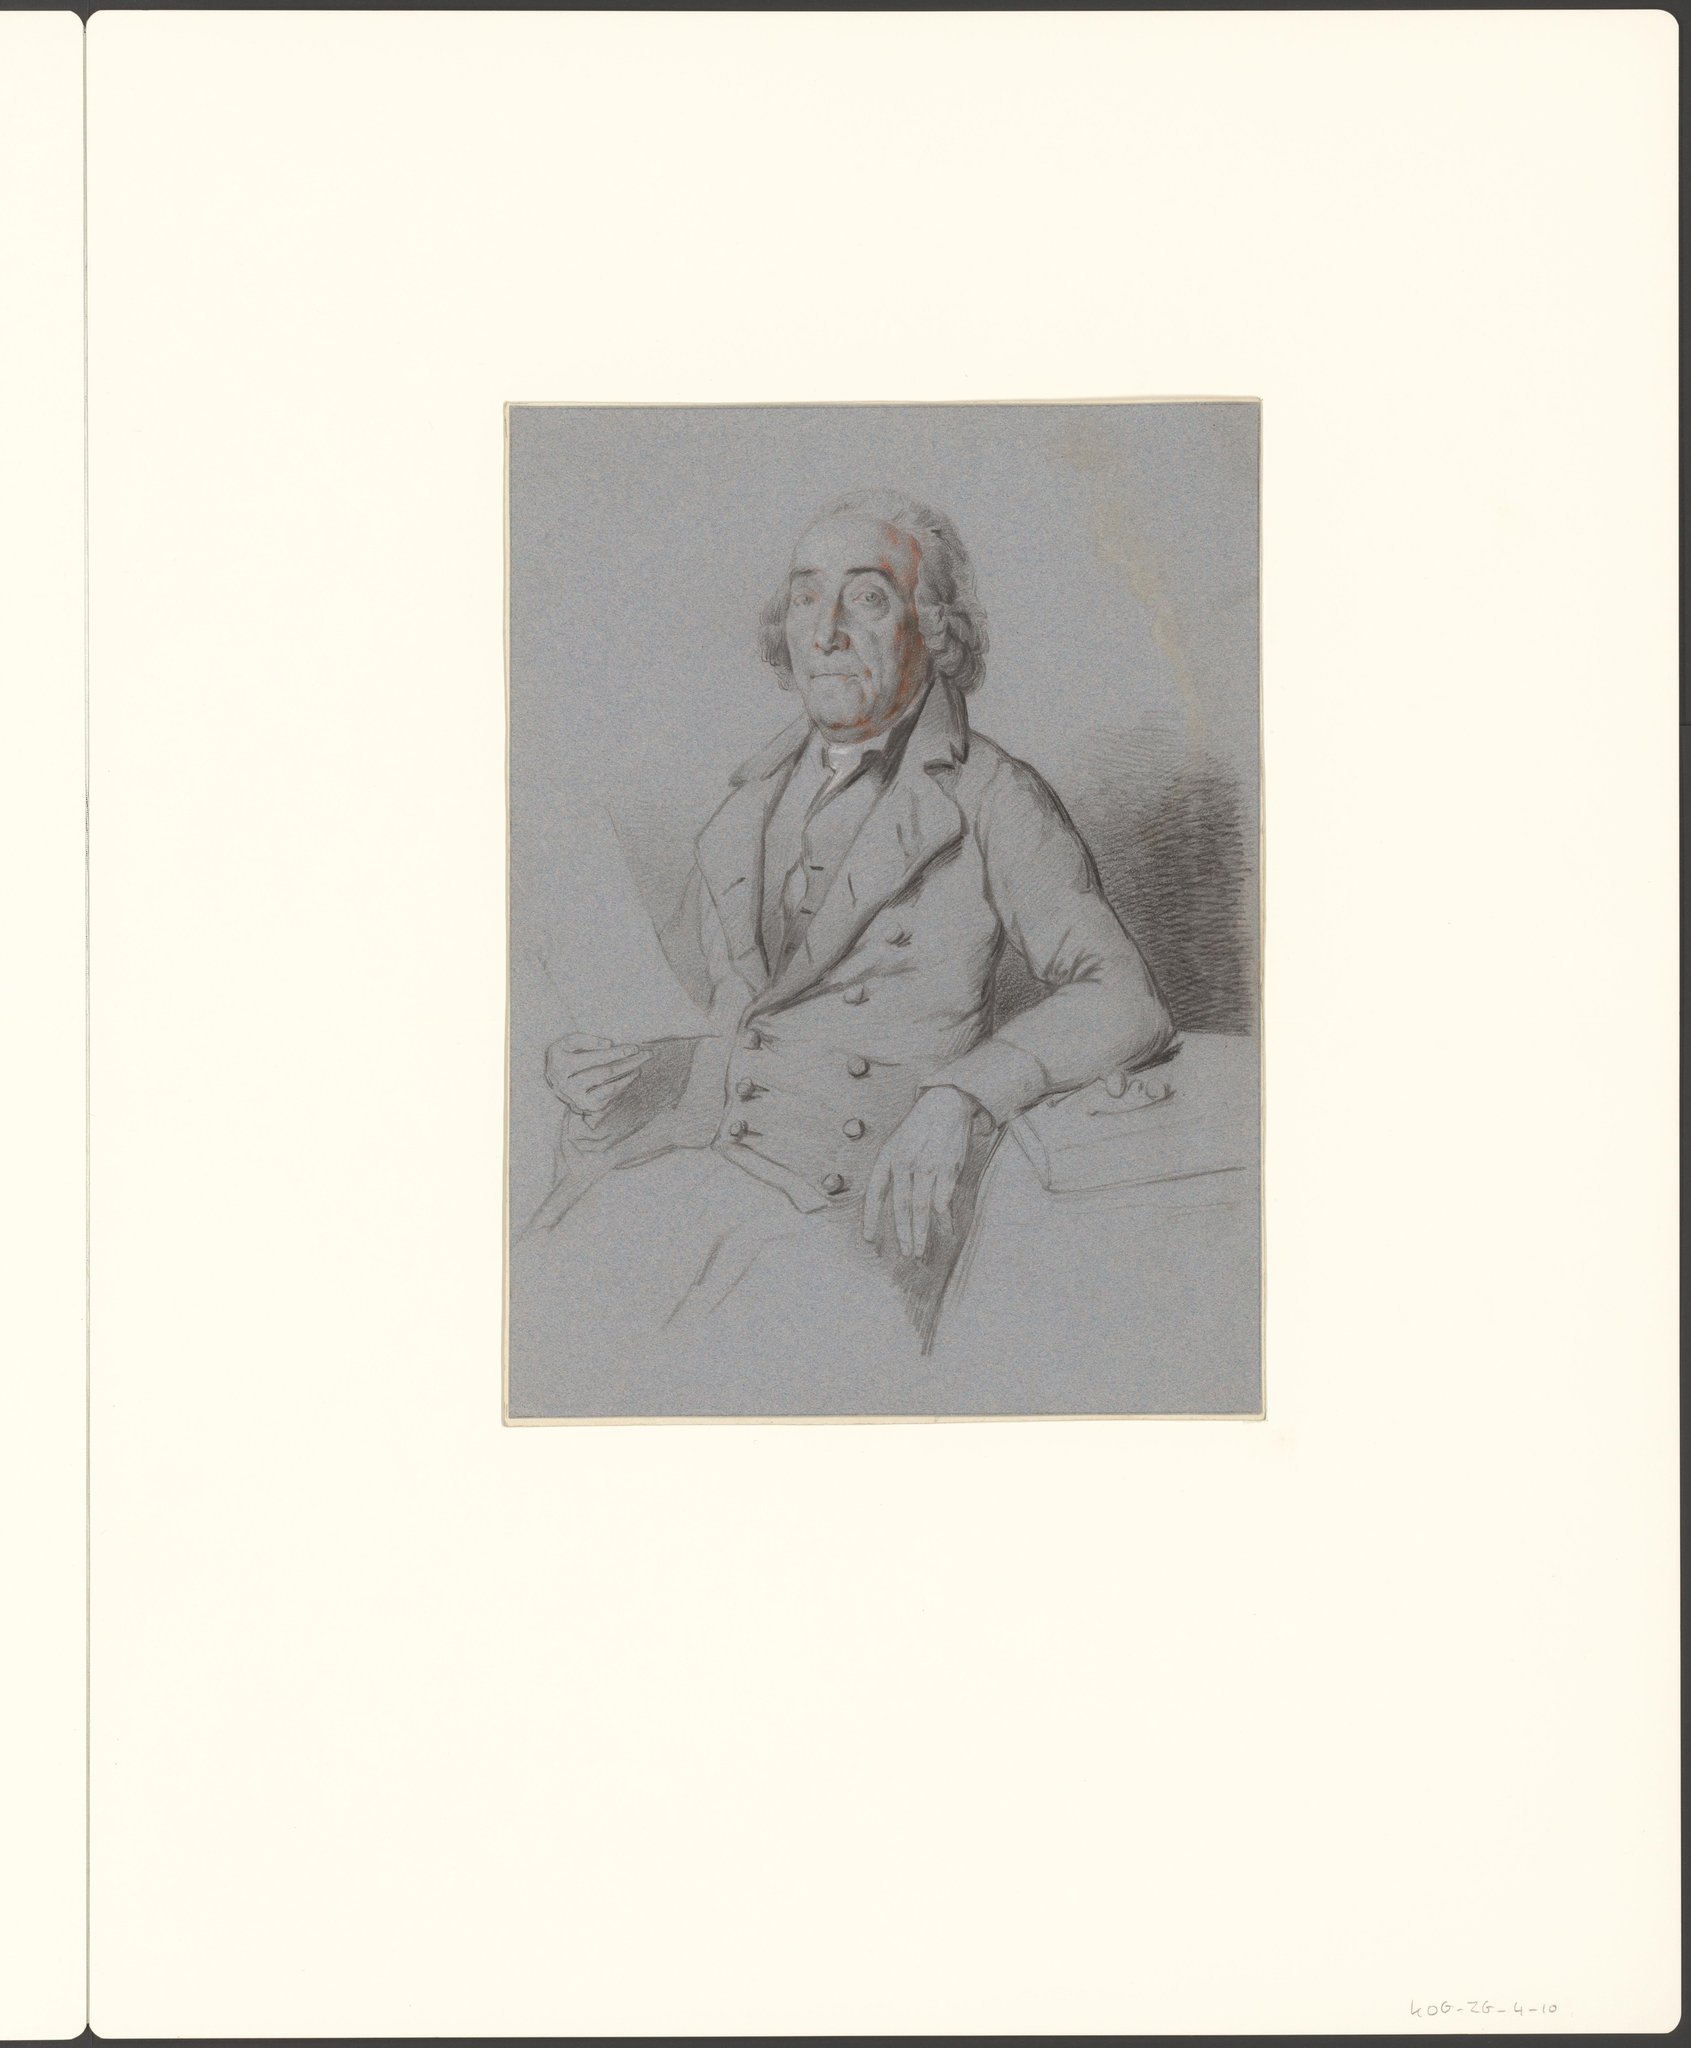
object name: drawing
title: Portret van Jacob de Vos Sr. (1735-1833)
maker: wybrand hendriks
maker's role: draughtsman, painter, print maker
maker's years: 1744-1831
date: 1811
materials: chalk, paper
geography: netherlands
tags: amsterdam, draughtsman, jacob de vos (1735-1833), historical persons, art collector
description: Portret van Jacob de Vos Sr., assurantiebezorger en kunstverzamelaar te Amsterdam. Zittend, in de rechterhand een blad papier. Hij leunt met de linkerarm op een boek dat op een tafel ligt. Zijn bril ligt op het boek. Hij draagt een pruik.